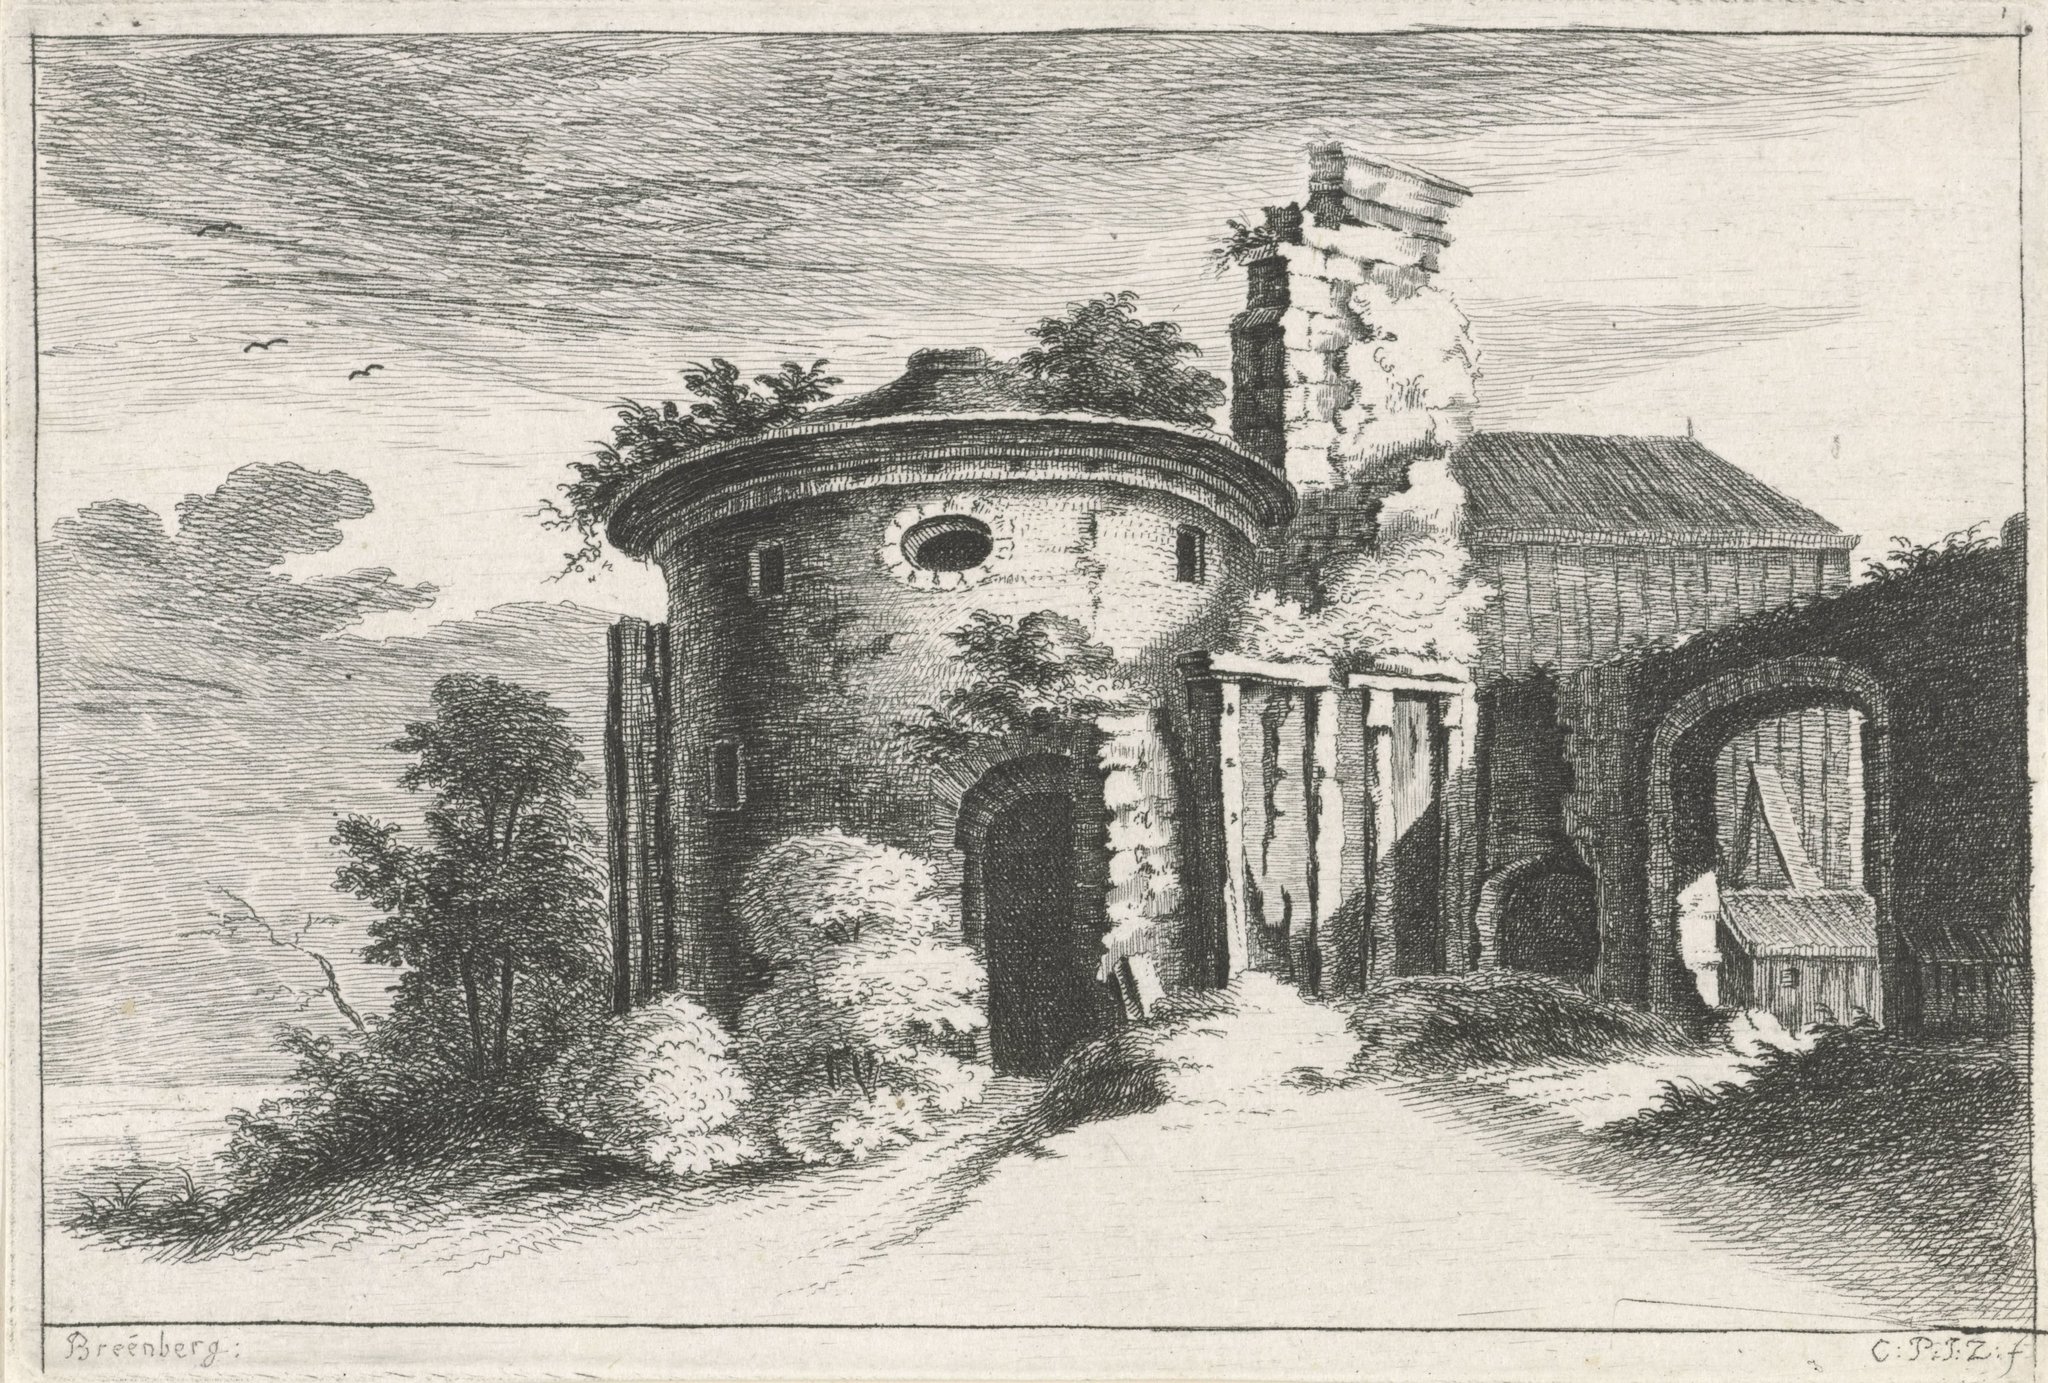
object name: print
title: Landschapjes, Rúwientjes enz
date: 1766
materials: paper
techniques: etching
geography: amsterdam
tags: temple, shrine ~ roman religion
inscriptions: collector's mark: Lugt 2228, collector's mark: Lugt 2760